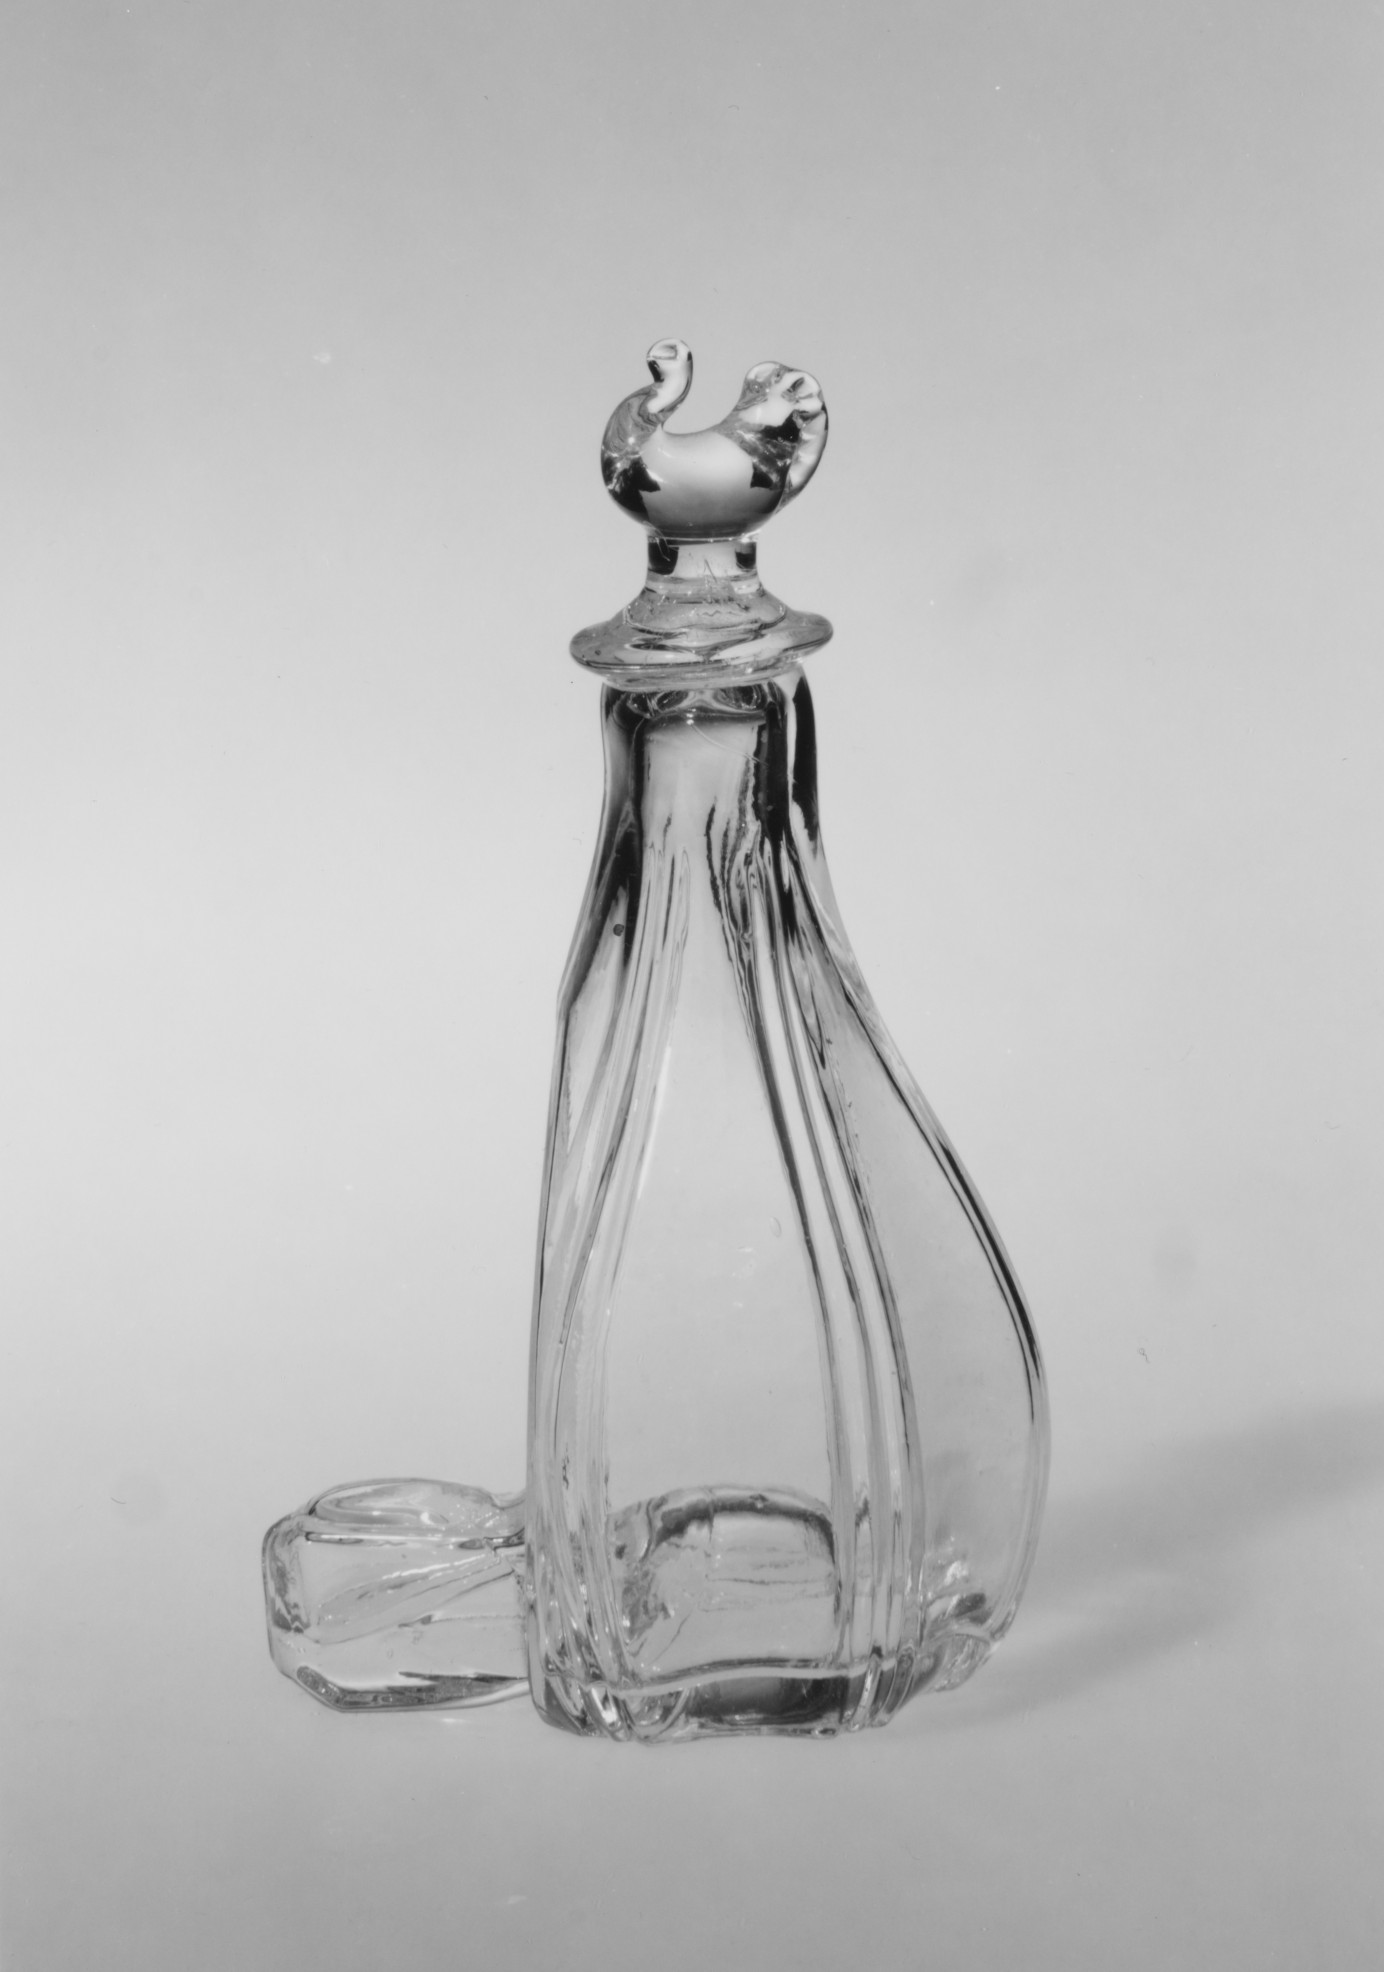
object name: fountain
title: Bird Fountain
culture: american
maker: boston & sandwich glass company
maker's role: maker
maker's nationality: american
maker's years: 1825-1888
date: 1820-1840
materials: glass, lead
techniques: glassblowing, molding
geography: united states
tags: birds,fountains